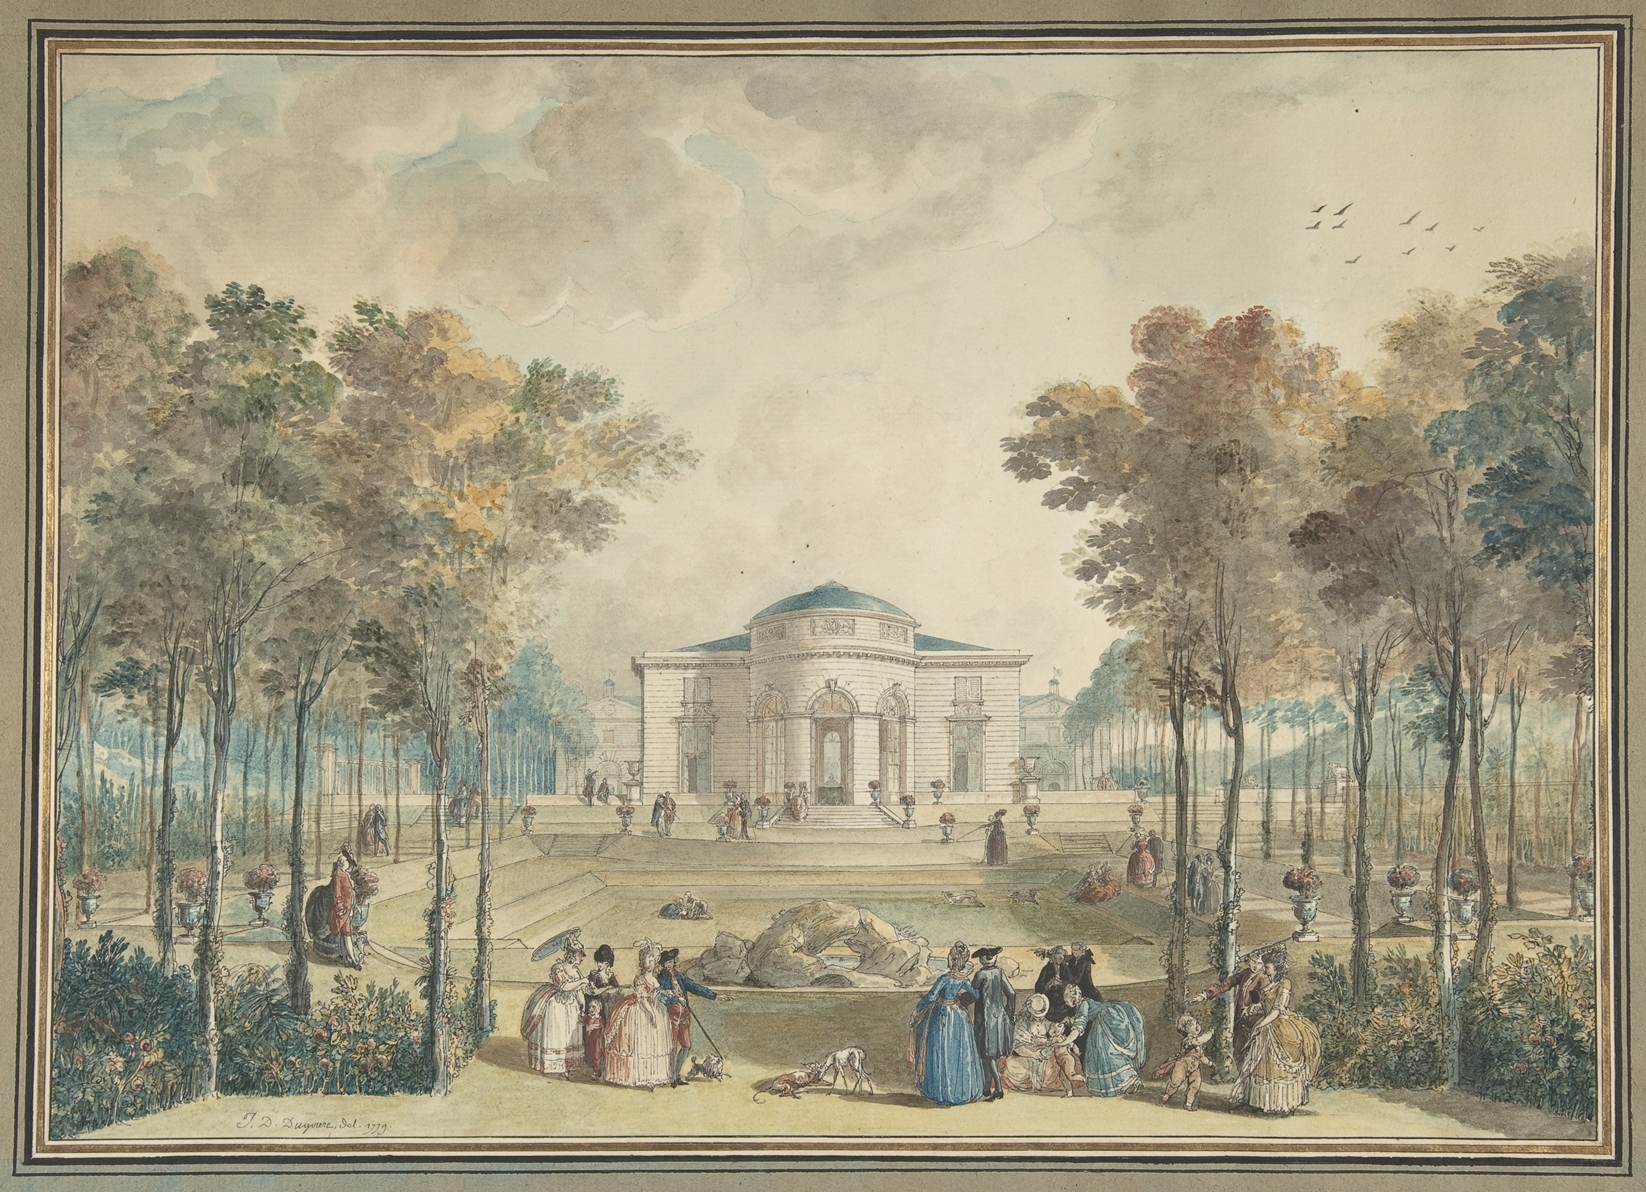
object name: drawing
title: The Garden Façade of Bagatelle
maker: jean démosthène dugourc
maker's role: designer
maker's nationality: french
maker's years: 1749-1825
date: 1779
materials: chalk, ink, watercolor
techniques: pen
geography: france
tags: human figures,gardens